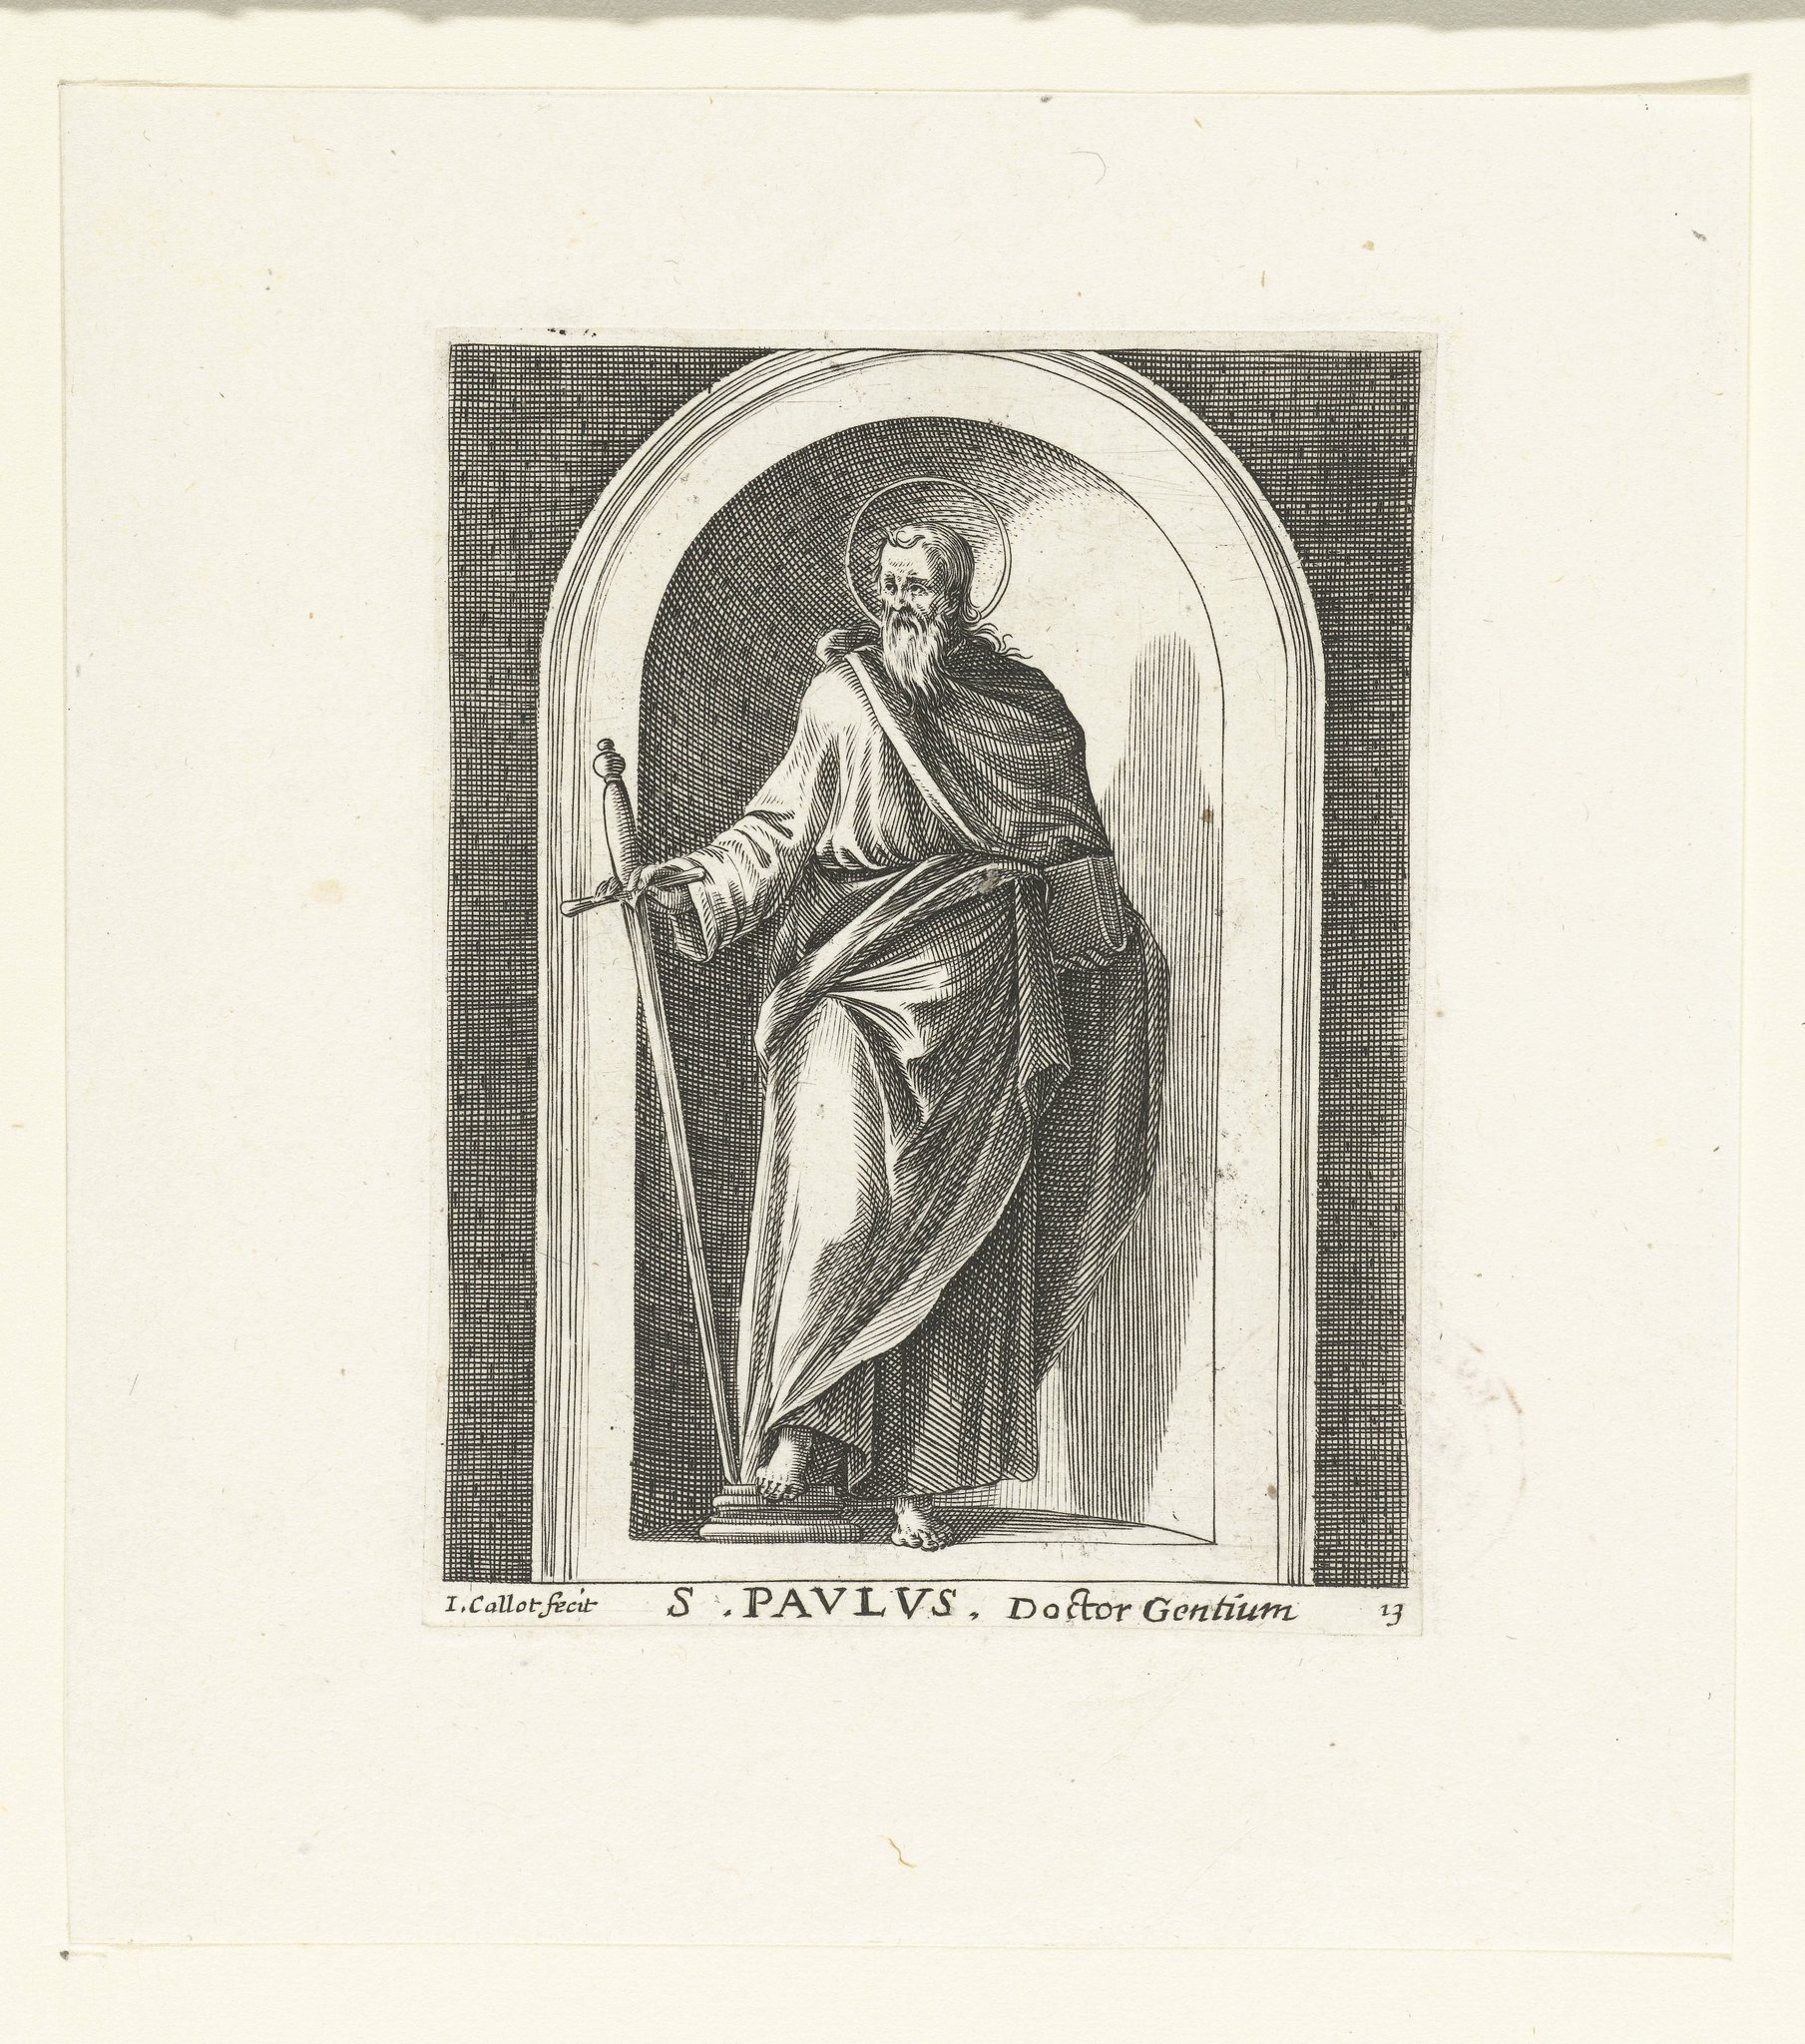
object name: print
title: Schilderijen en sculpturen te Rome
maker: jacques callot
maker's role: draughtsman, print maker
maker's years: 1592-1635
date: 1608-1611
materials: paper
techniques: engraving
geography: rome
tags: the apostle paul of tarsus; possible attributes: book, scroll, sword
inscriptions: collector's mark: Lugt 240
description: De Heilige Paulus, staand in een nis, een zwaard in de rechterhand, een boek in de linkerhand. Onder de voorstelling een onderschrift in Latijn. Deze prent is onderdeel van (de tweede staat van) een serie van 29 voorstellingen van schilderijen en sculpturen in kerken te Rome, genummerd 1-16 en 1-13. (De eerste staat van deze serie, waarin de prenten ongenummerd zijn, behelst ook een titelprent).